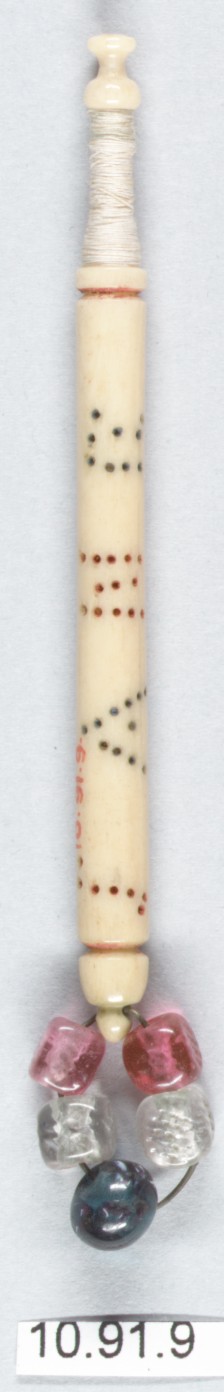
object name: bobbin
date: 1801-1900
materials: bone